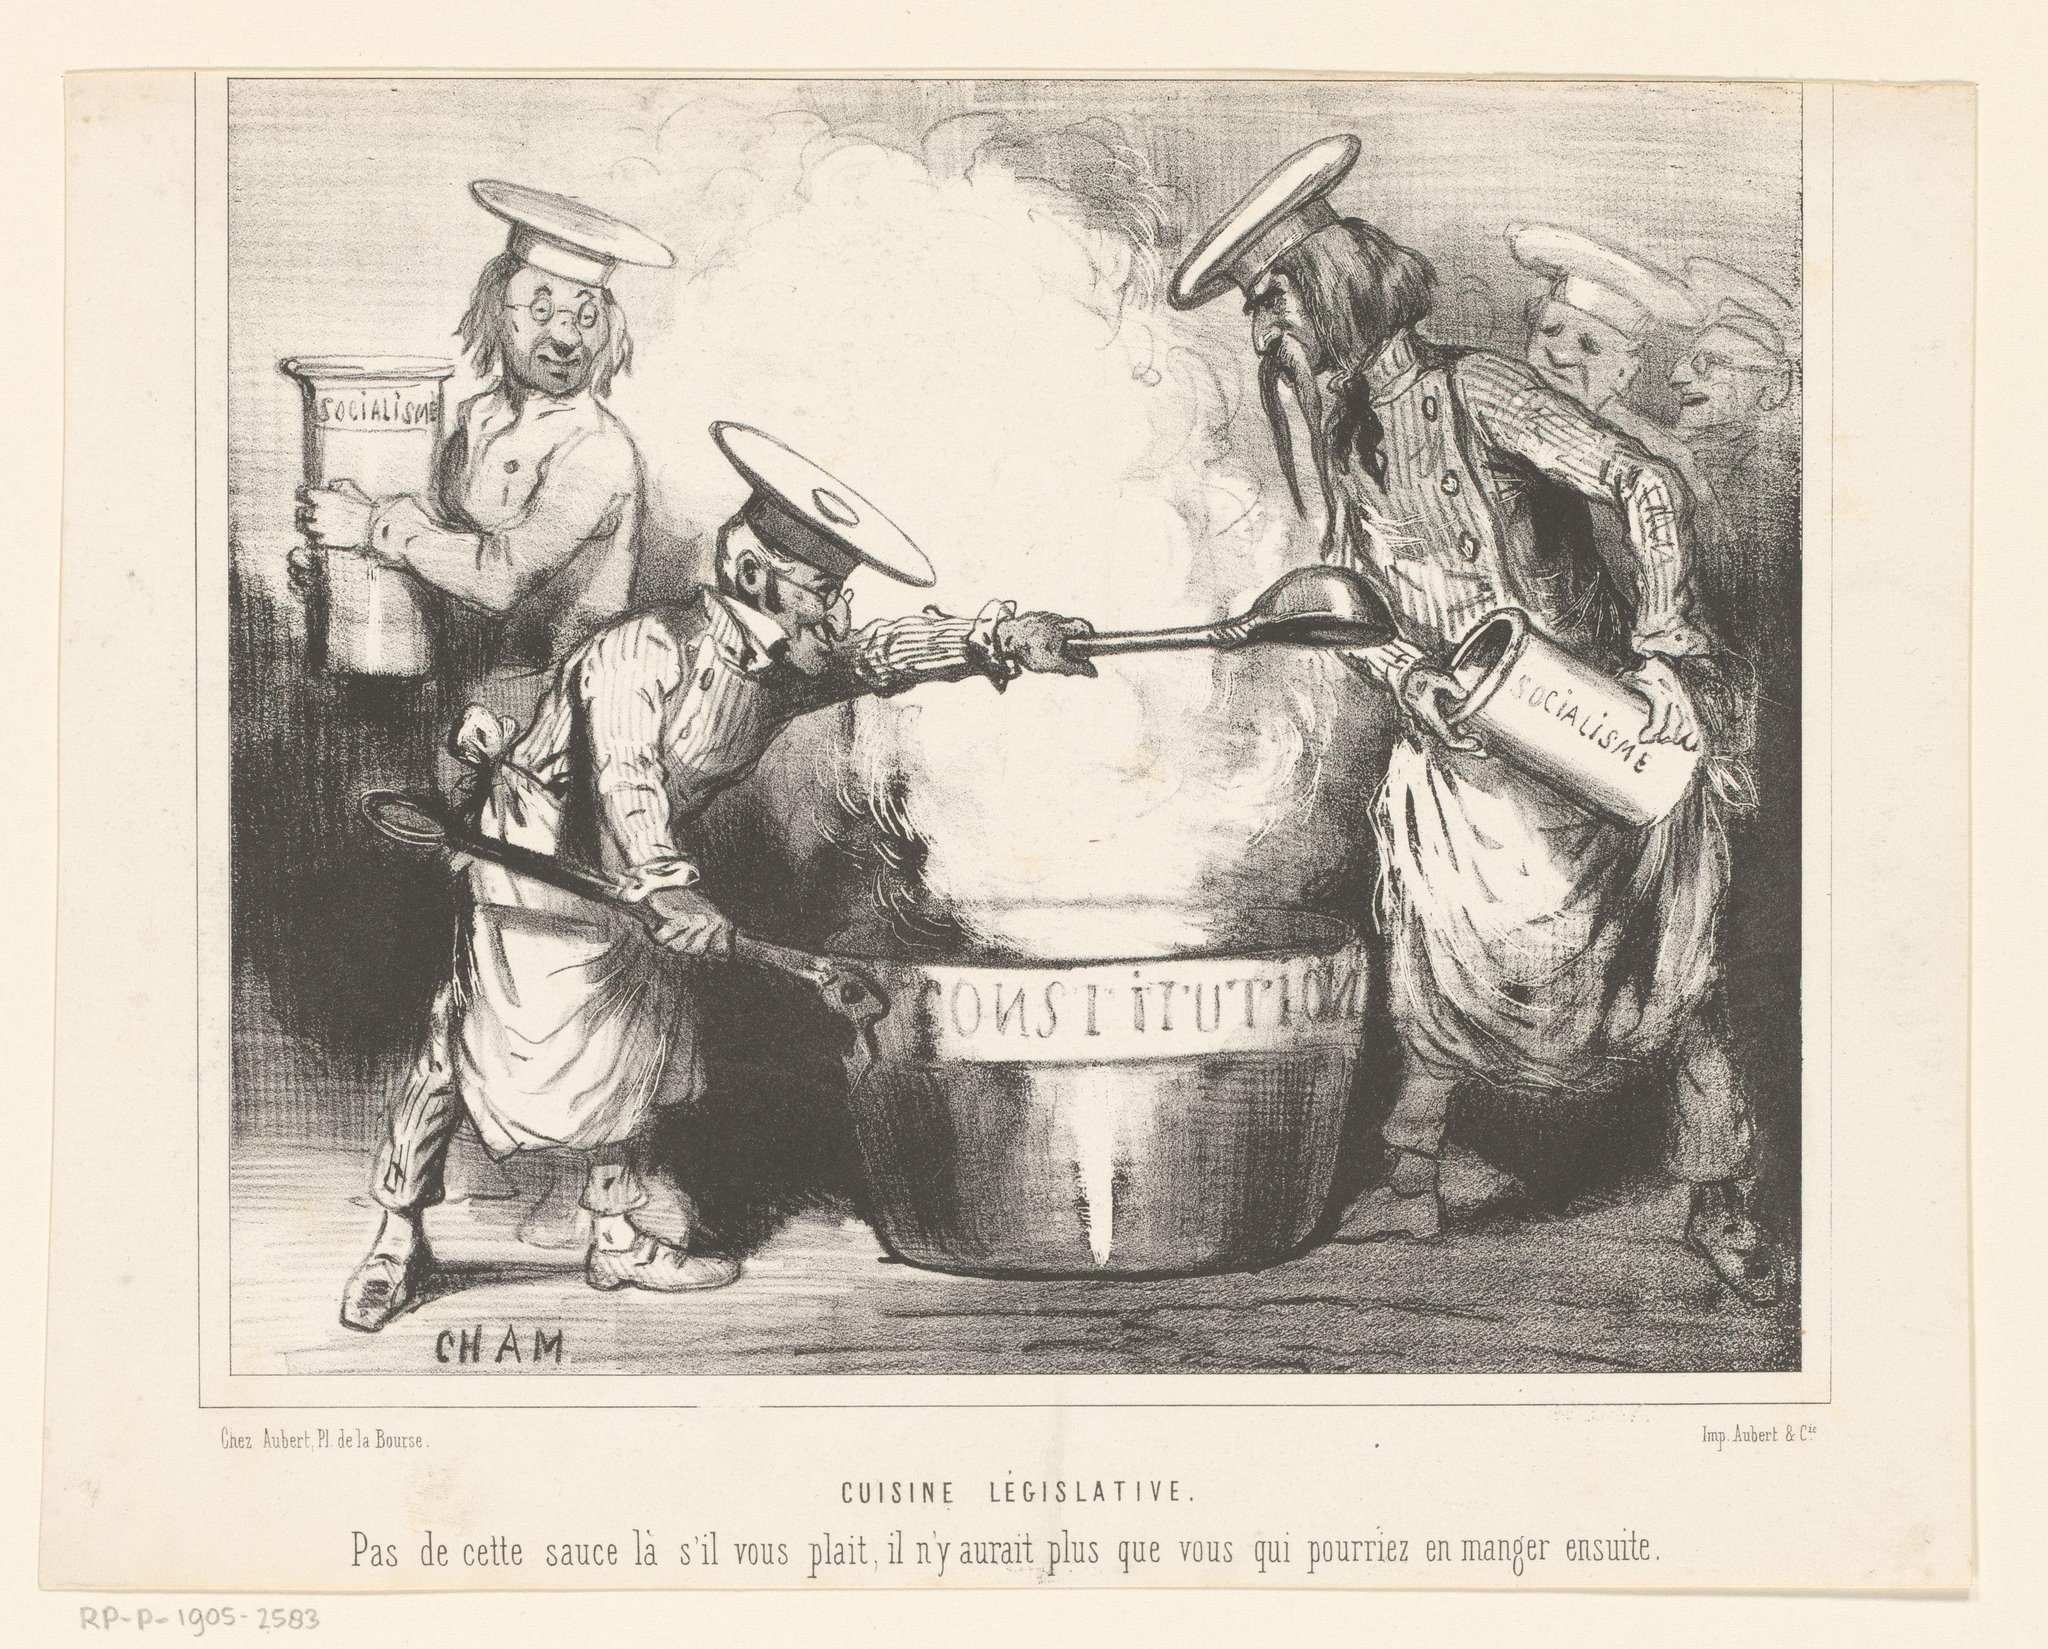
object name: cartoon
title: Koks voegen socialisme toe aan de pan van de grondwet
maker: cham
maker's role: print maker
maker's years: 1818-1879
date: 1848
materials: paper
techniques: lithograph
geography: paris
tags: kitchen-utensils: pot, legendary origin of law; legendary lawgiver, political caricatures and satires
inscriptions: collector's mark: Lugt 2228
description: Prent verschenen in: Le Charivari 17 (1848), nr. 295, 21 oktober 1848. 155e prent uit serie van 217 prenten.